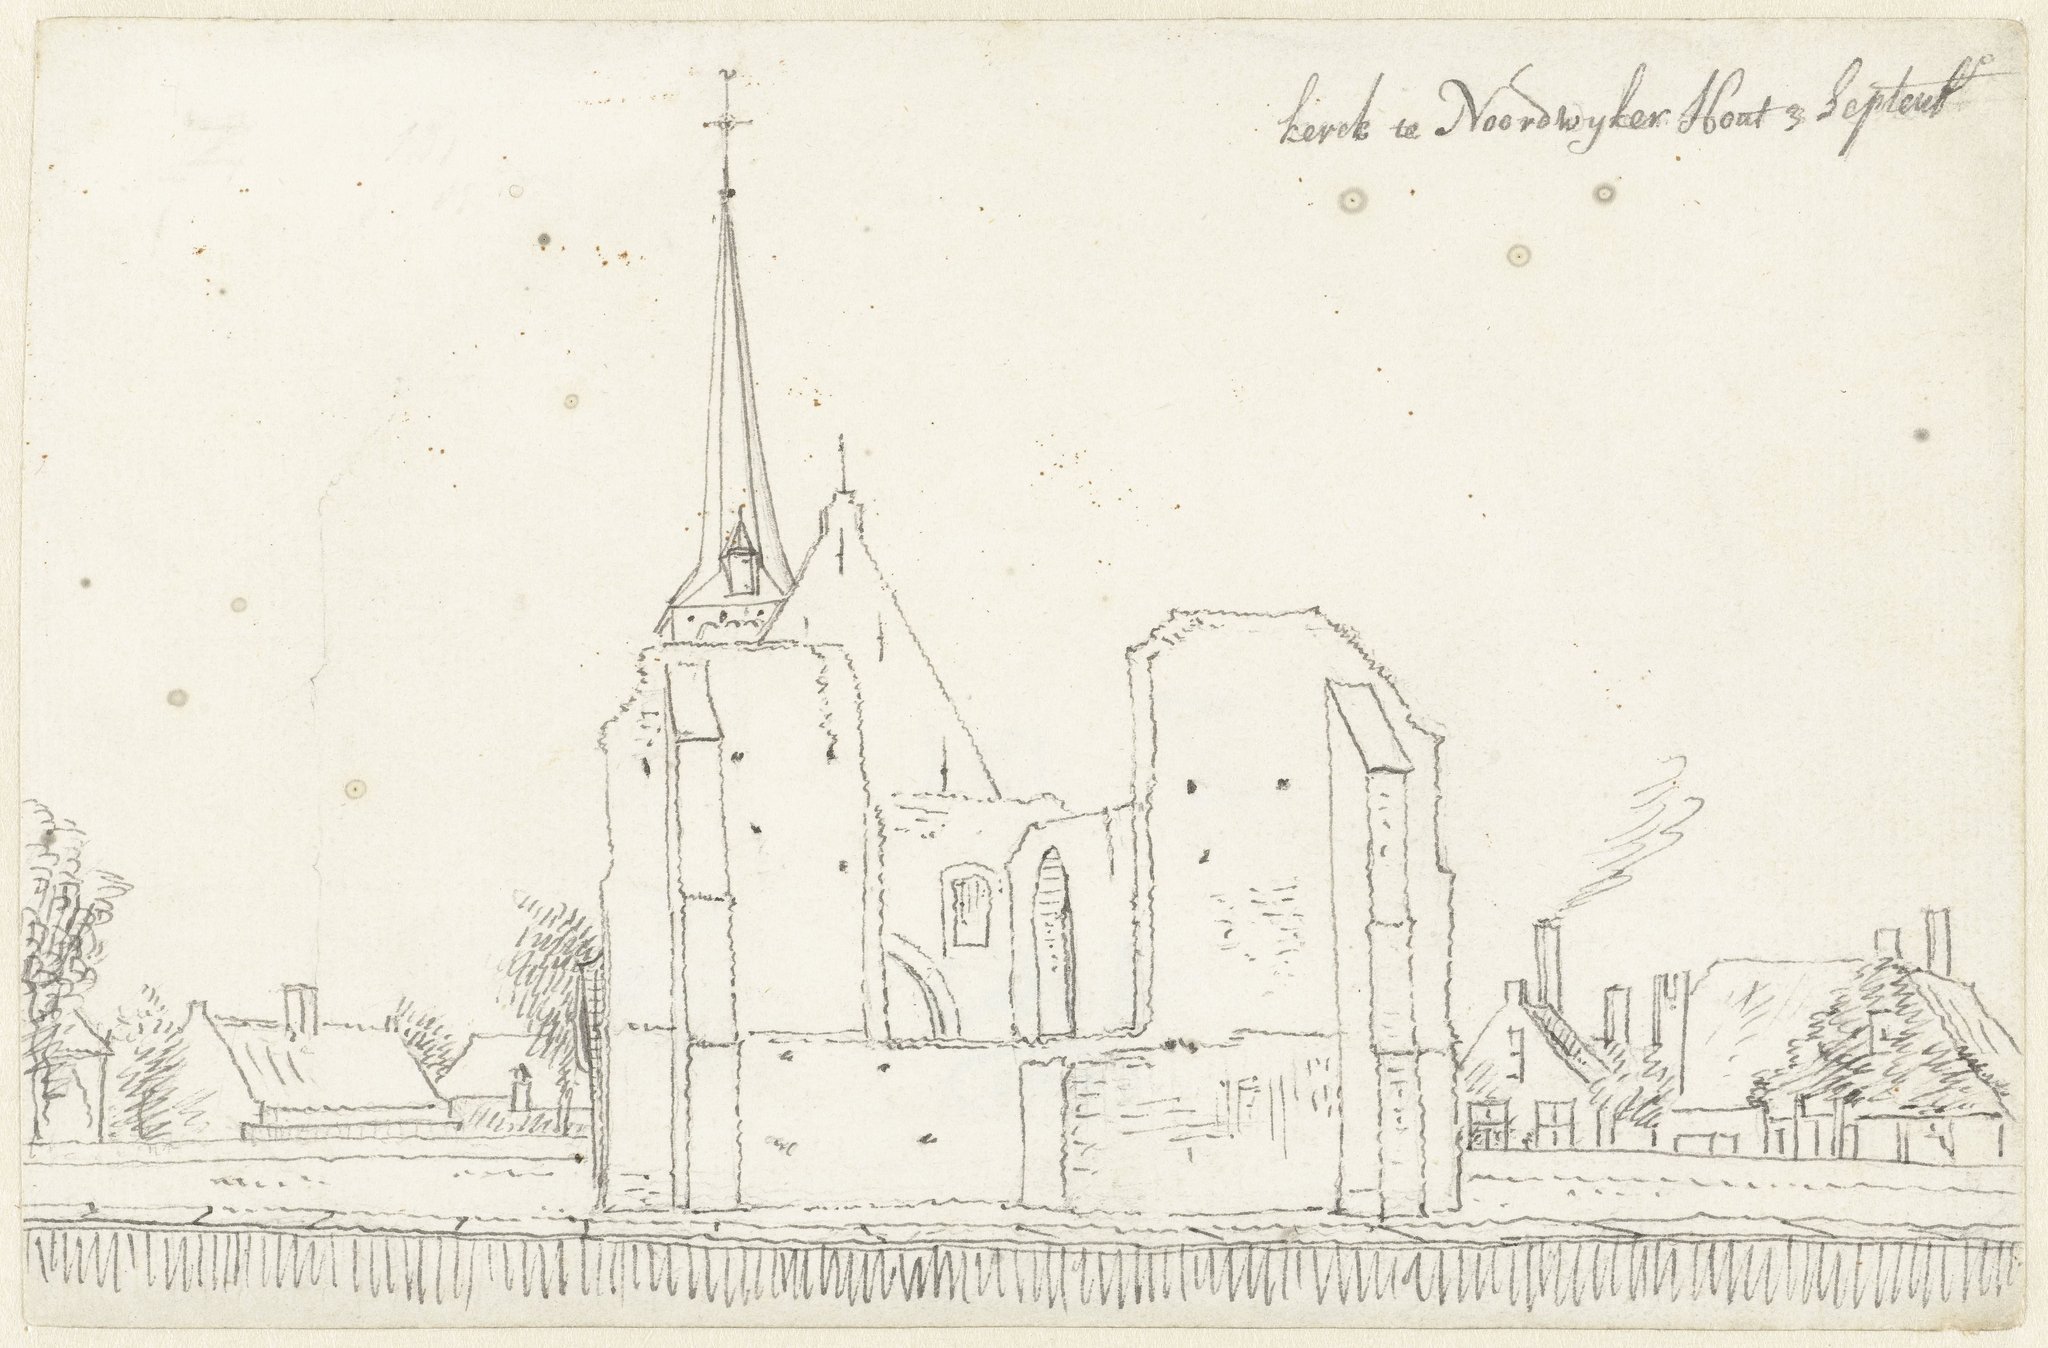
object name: drawing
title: De kerk te Noordwijkerhout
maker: cornelis pronk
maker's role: draughtsman, painter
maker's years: 1691-1759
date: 1701-1759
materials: ink, paper, pencil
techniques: pen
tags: church (exterior), ruin of church, monastery, etc.